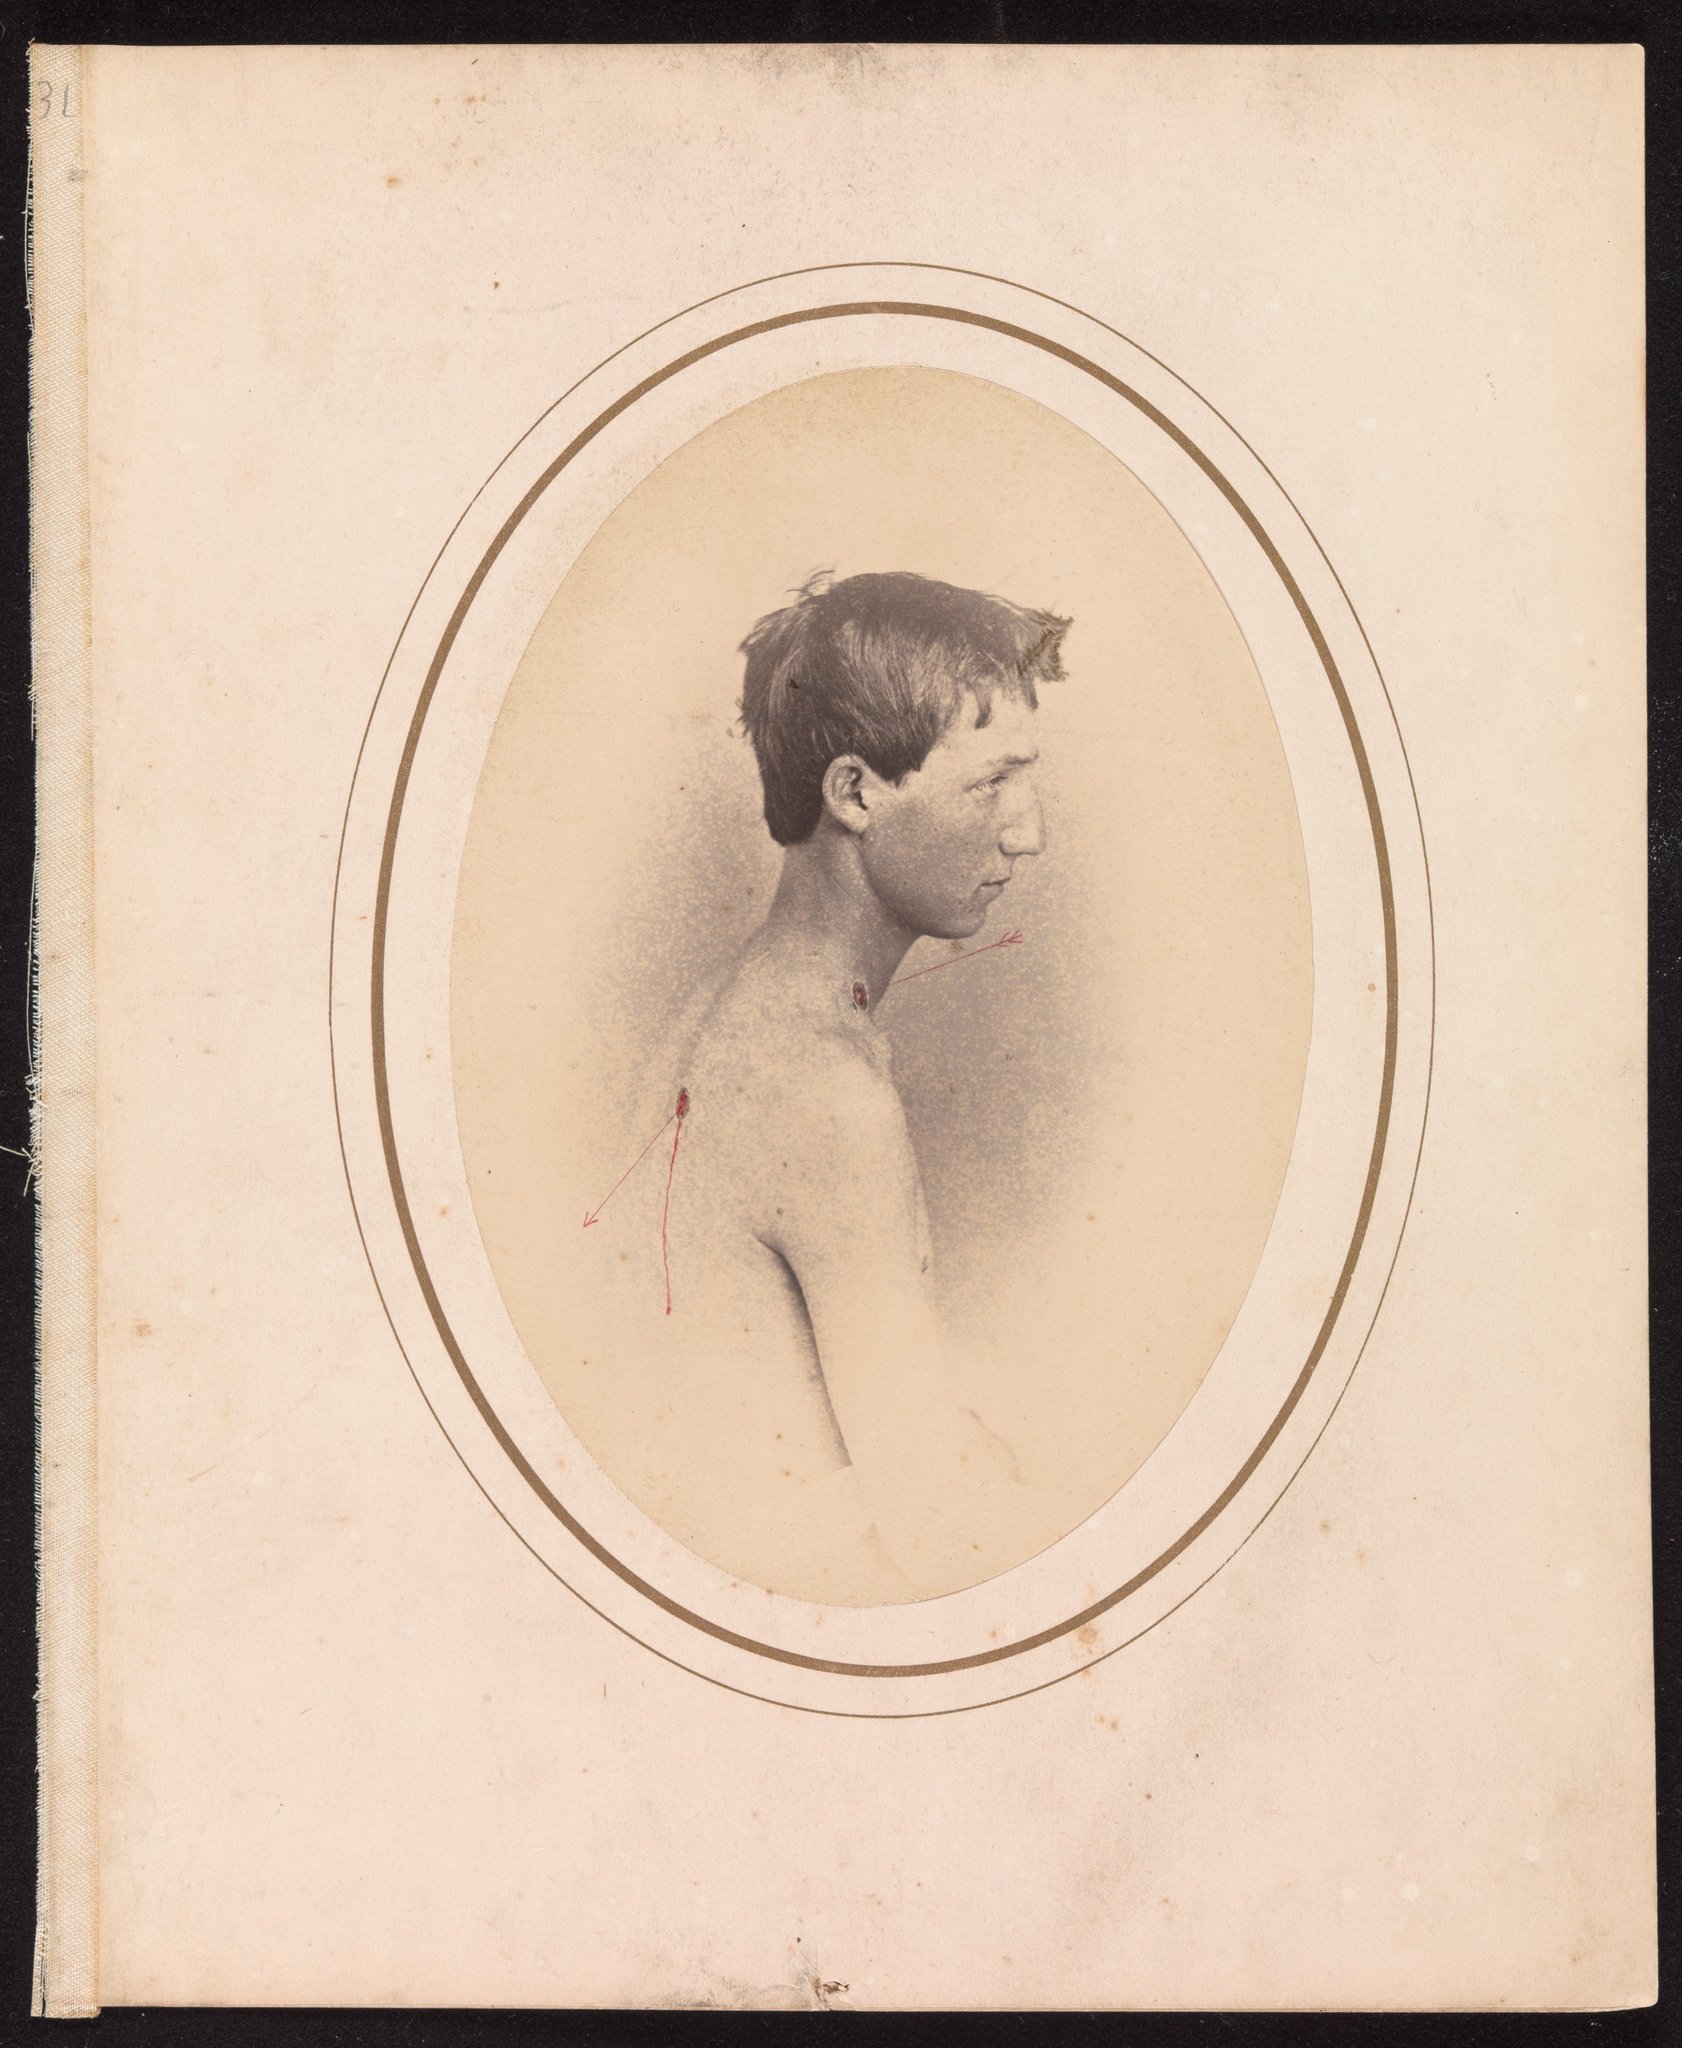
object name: photograph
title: Private Jacob F. Simmons, Company H, Eighty-second Pennsylvania Volunteers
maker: reed brockway bontecou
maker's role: artist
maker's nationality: american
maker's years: 1824-1907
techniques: albumen silver print, glass negative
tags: soldiers,american civil war,men,portraits,profiles